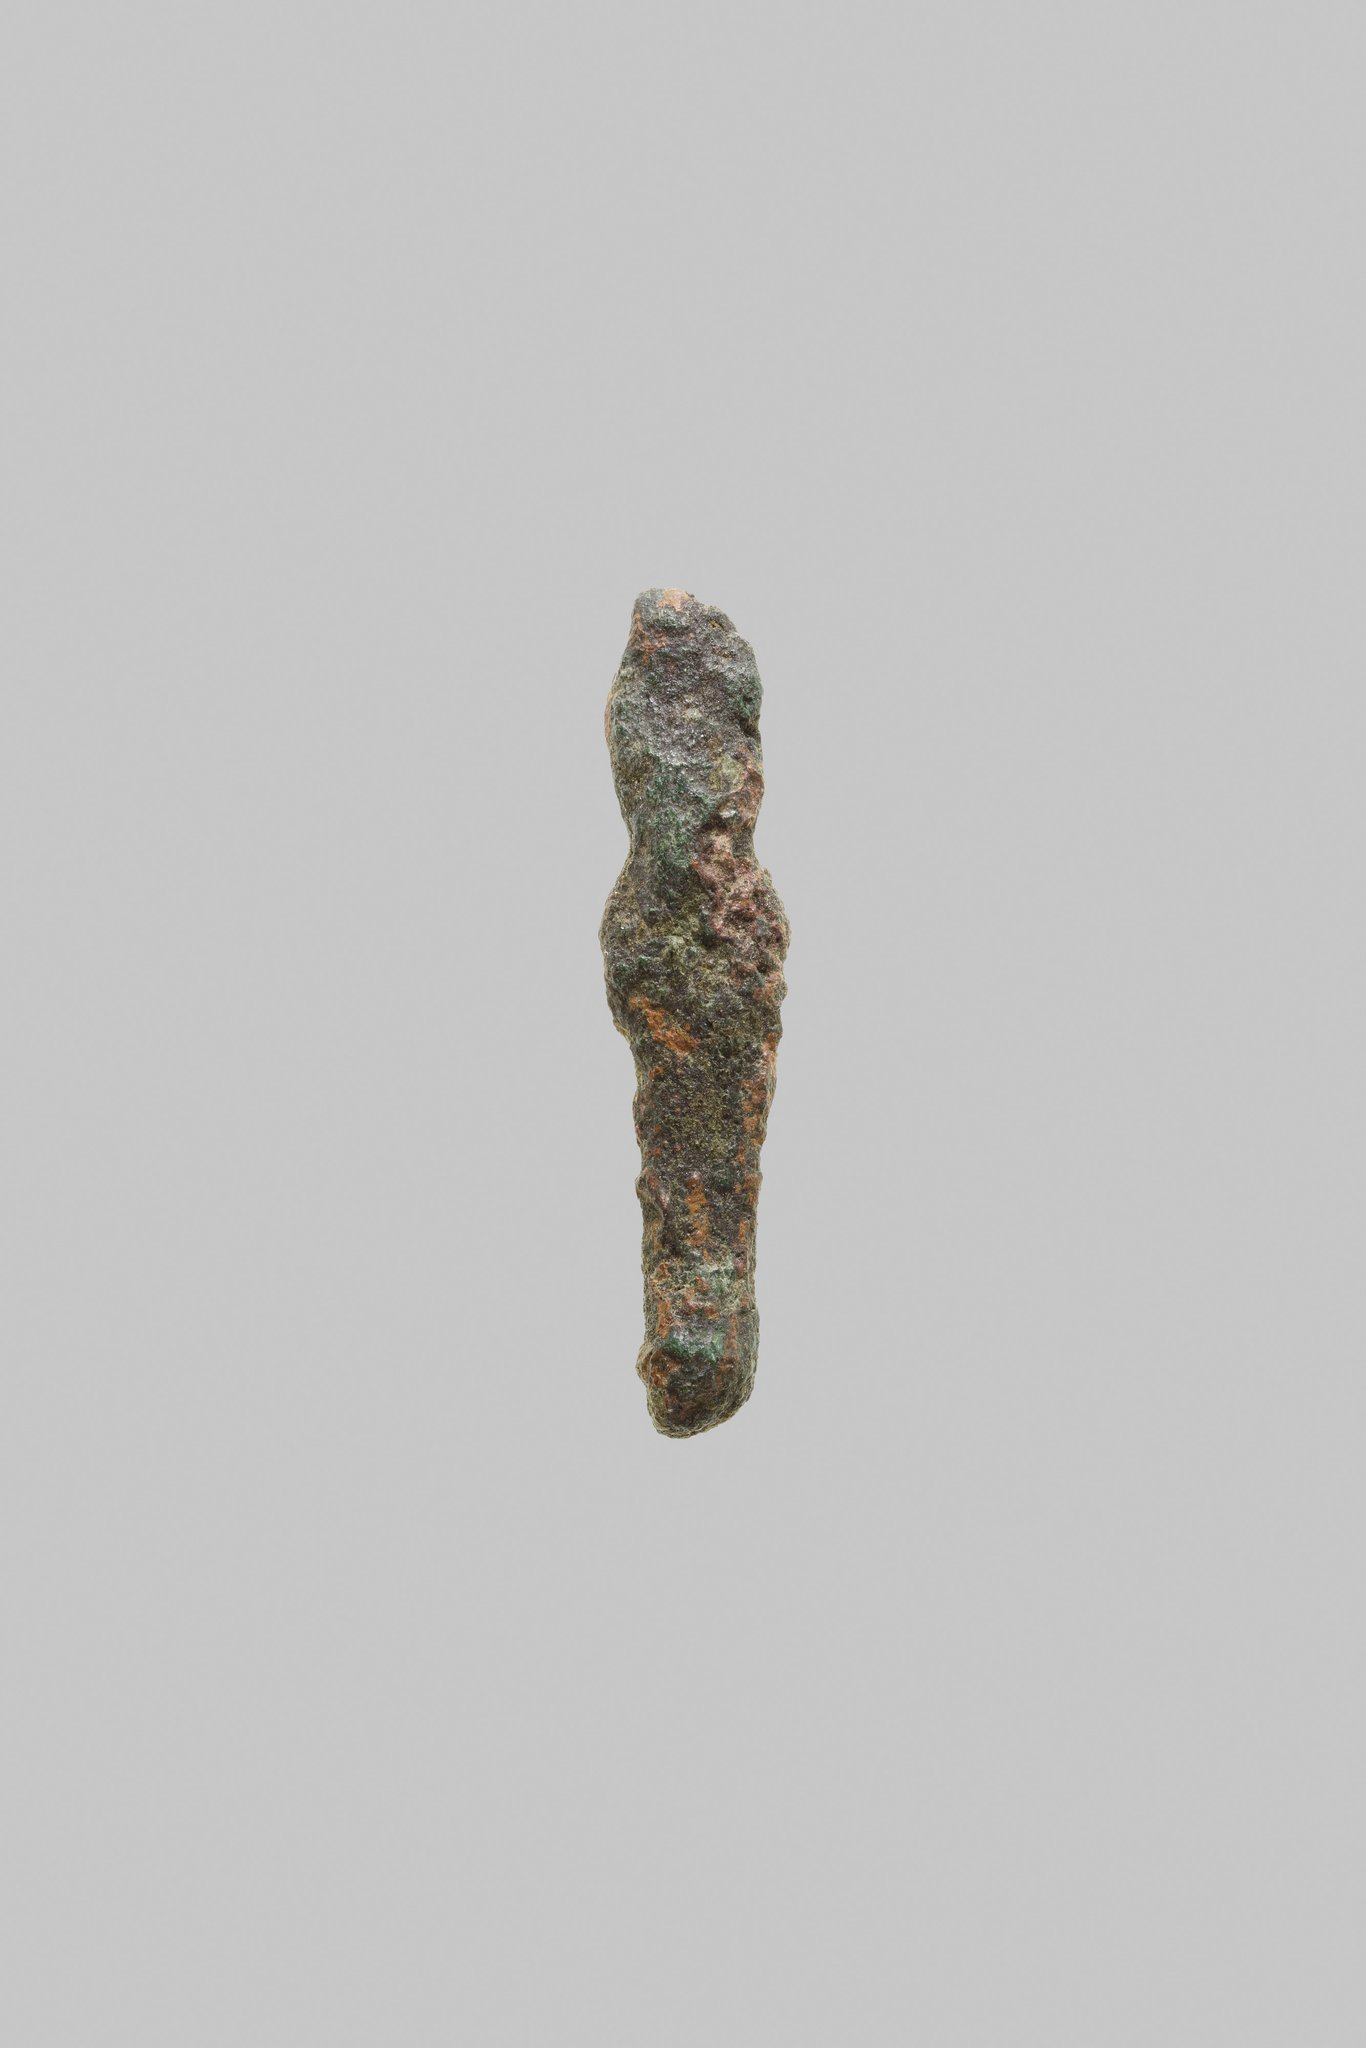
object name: statuette, osiris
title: Statuette of Osiris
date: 712-30 BCE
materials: bronze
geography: egypt